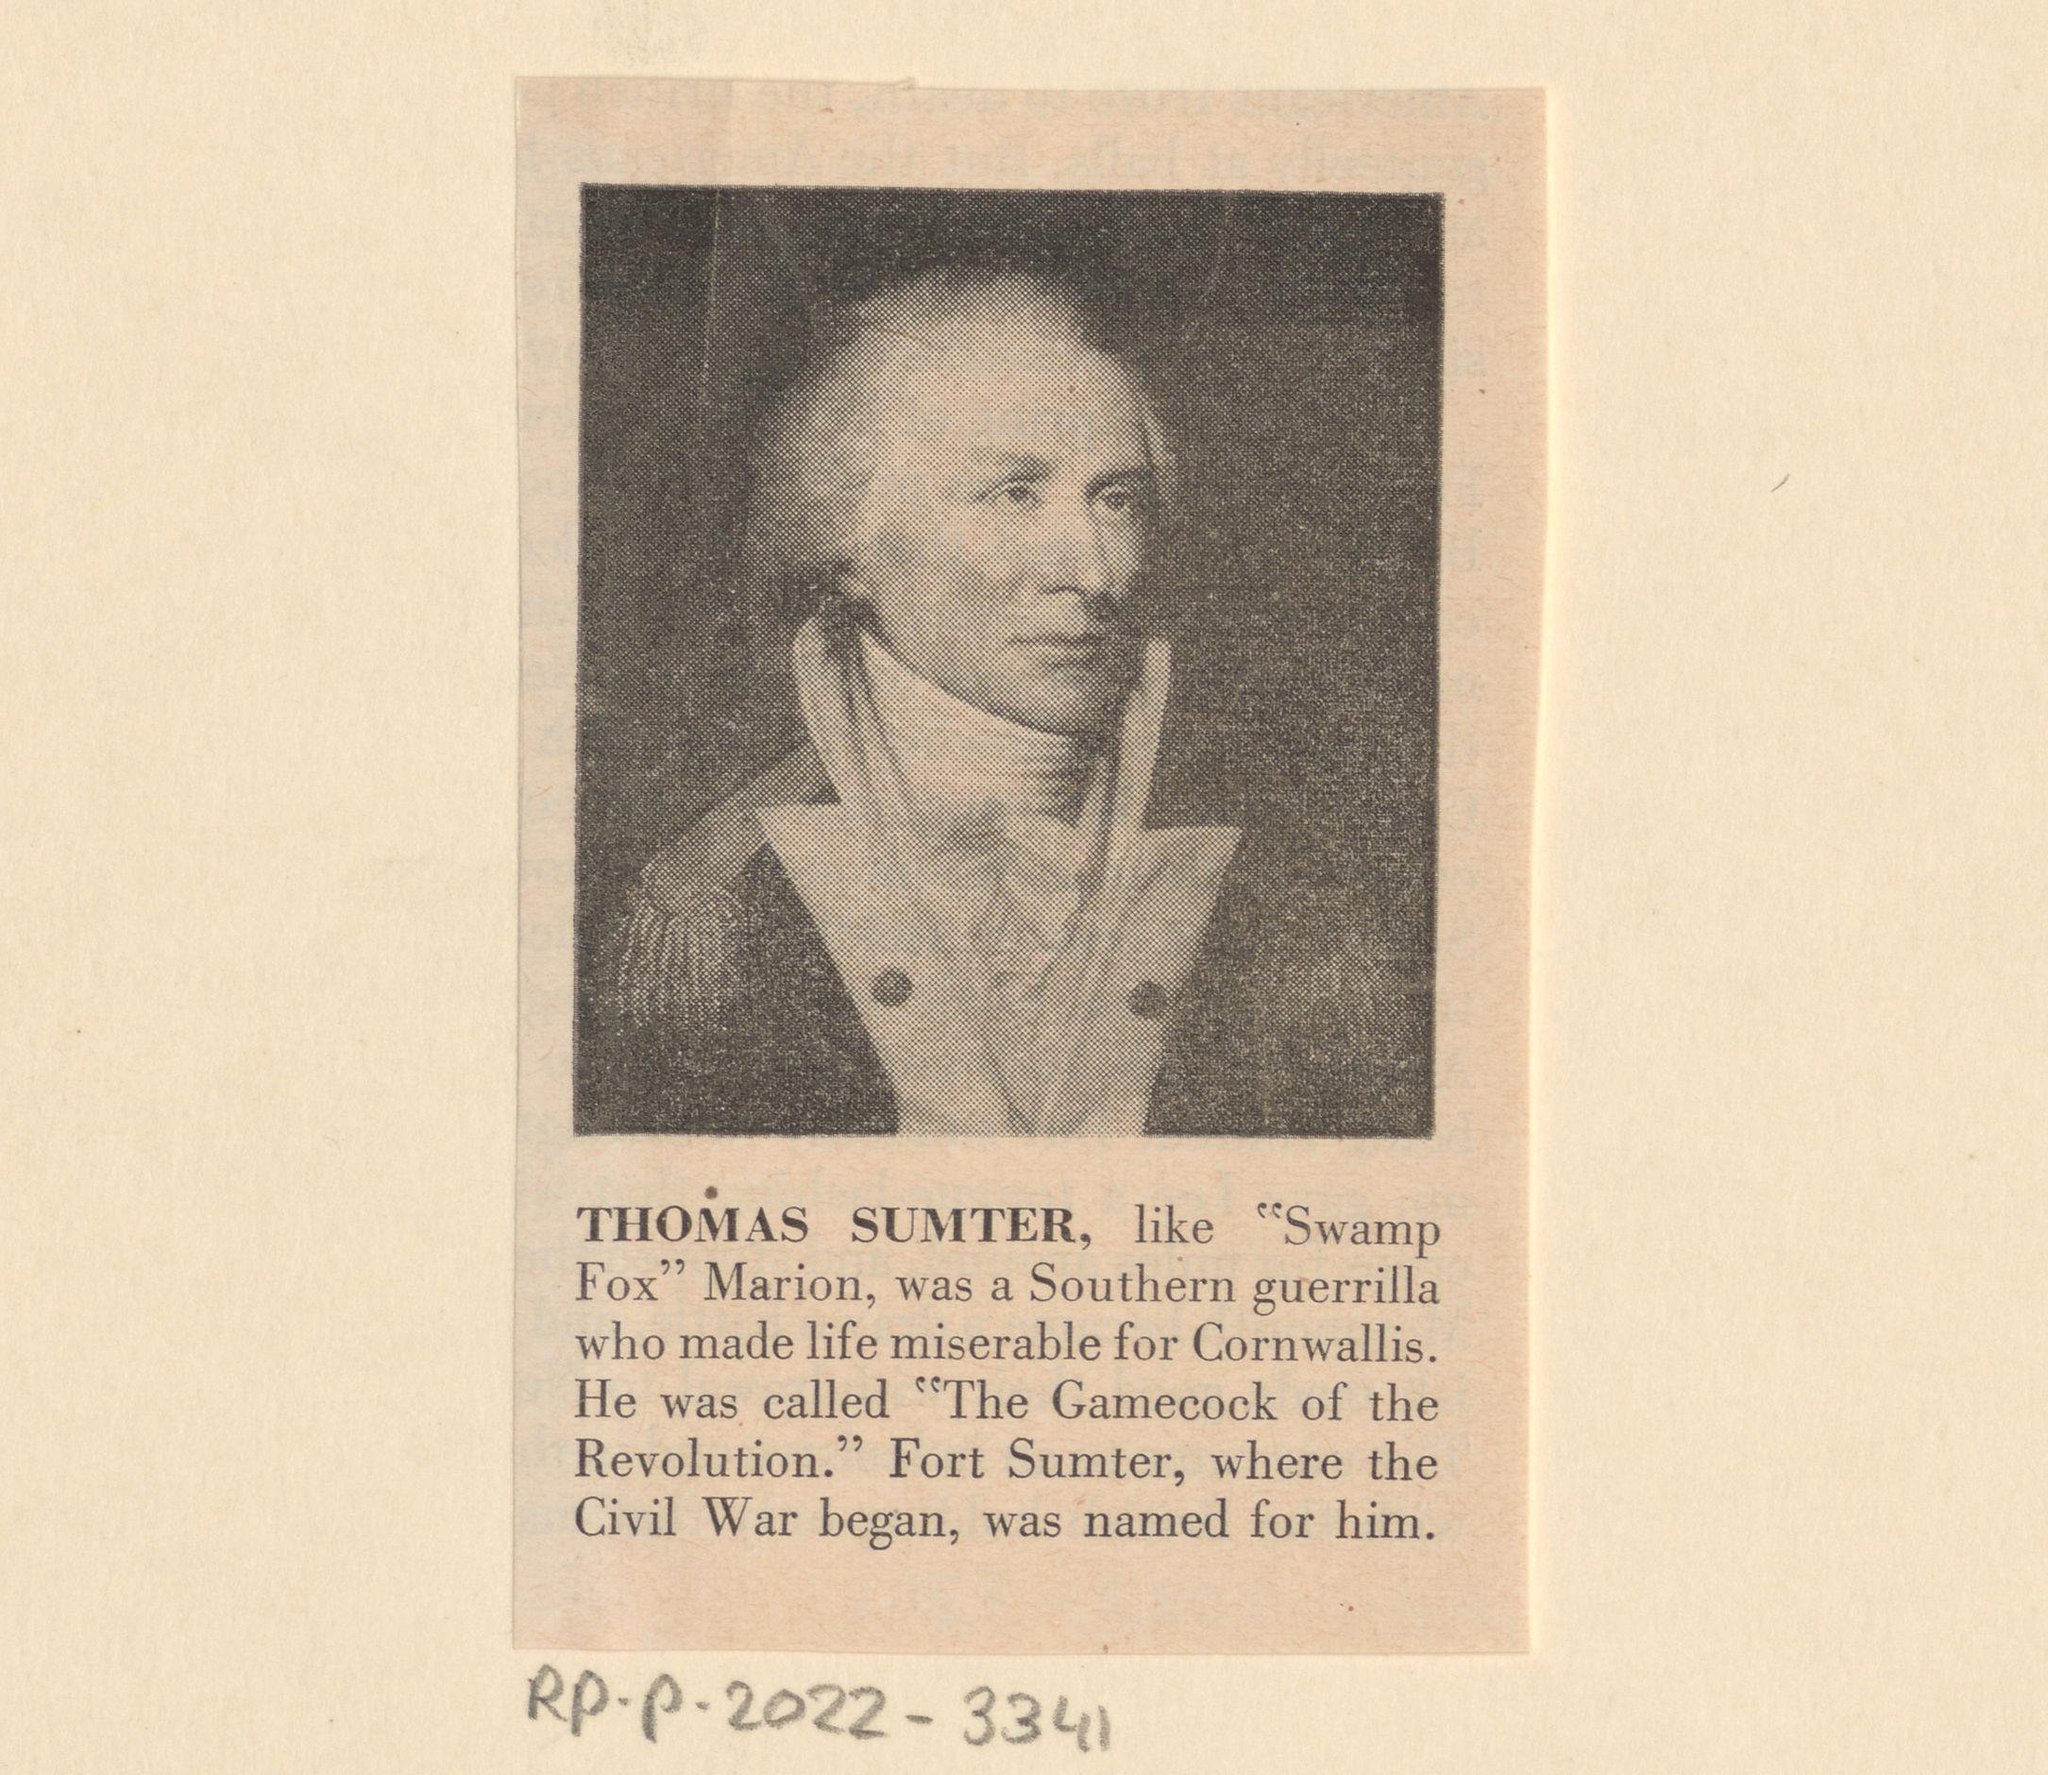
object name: photomechanical print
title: Portret van Thomas Sumter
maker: Anonymous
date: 1950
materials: paper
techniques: letterpress printing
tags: historical persons, officer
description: Prent uit: Life Magazine, vol 29.1 (1950), p. 52.